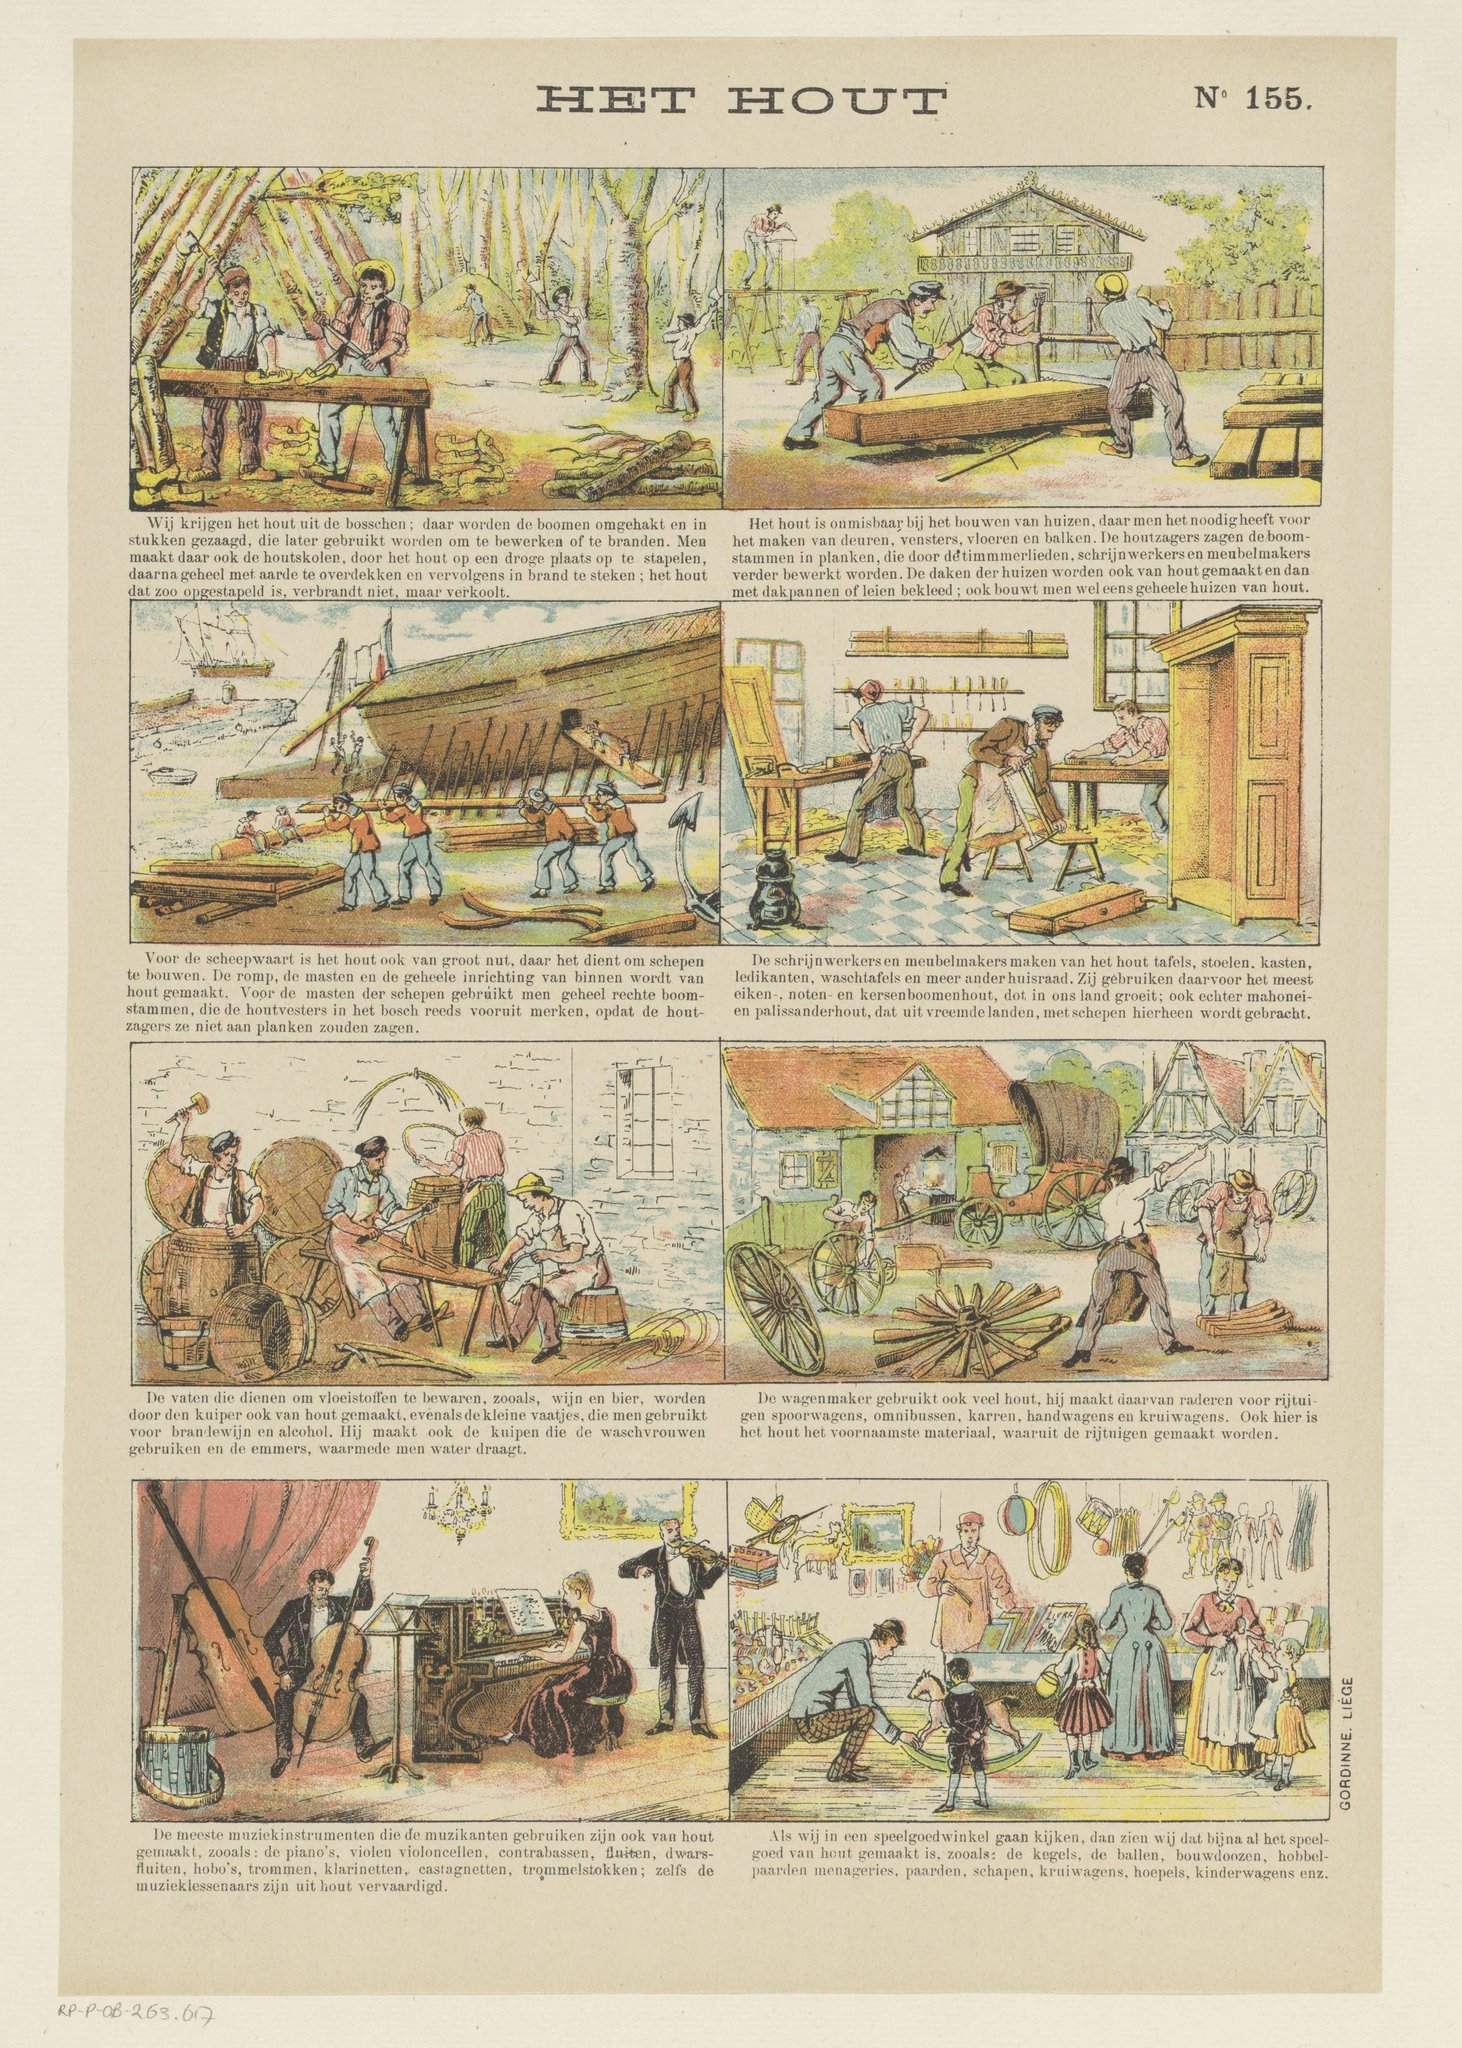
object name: print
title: Het hout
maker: a. de ker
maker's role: print maker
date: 1894-1959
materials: paper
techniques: lithograph, letterpress printing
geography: liège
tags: turner in wood, industries ~ wood, handicrafts ~ wood, timber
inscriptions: collector's mark: Lugt 2760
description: Blad met 8 voorstellingen over houtbewerking. Onder elke afbeelding een onderschrift. Genummerd rechtsboven: No 155.